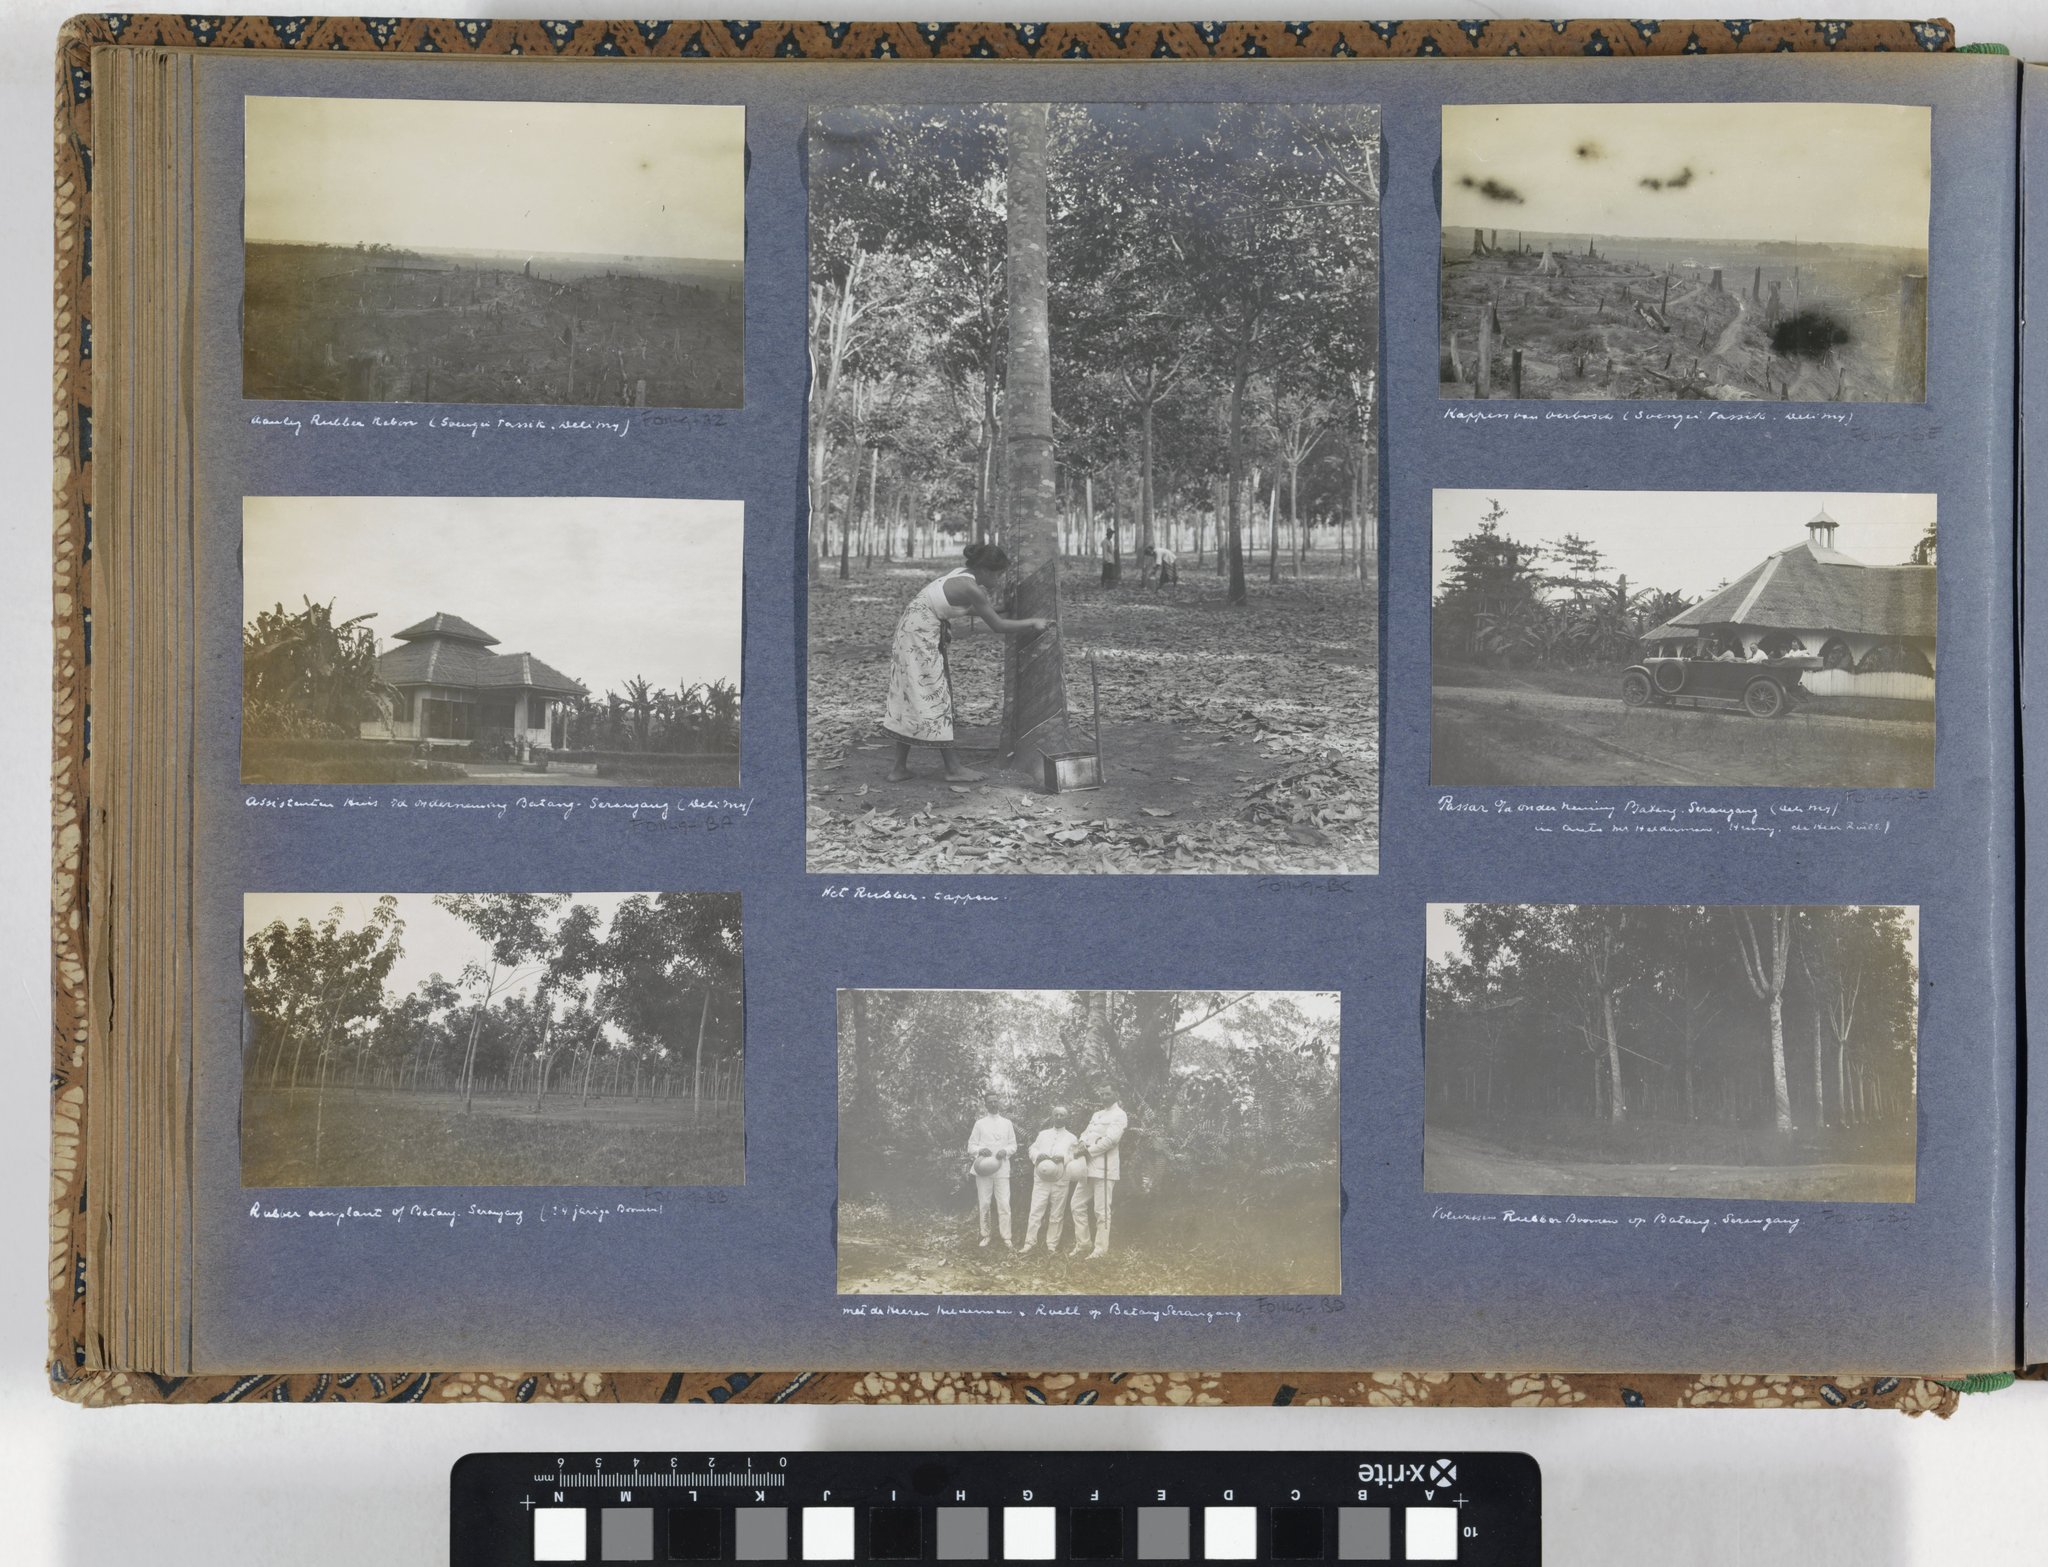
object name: album leaf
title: Aanleg van een rubberplantage van de Deli Maatschappij bij Soengei Tassik op Sumatra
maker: Anonymous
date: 1900-1920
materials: paper, photographic support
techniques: gelatin silver print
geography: sumatra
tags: plantation, (non-fruit) products of plants or trees: rubber, clearing ~ forest (+ outdoors; in the open air), sumatra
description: Onderdeel van reisalbum met foto's van bedrijvigheid en bezienswaardigheden op Sumatra en Java en van de reis naar en van Nederlands-Indië.